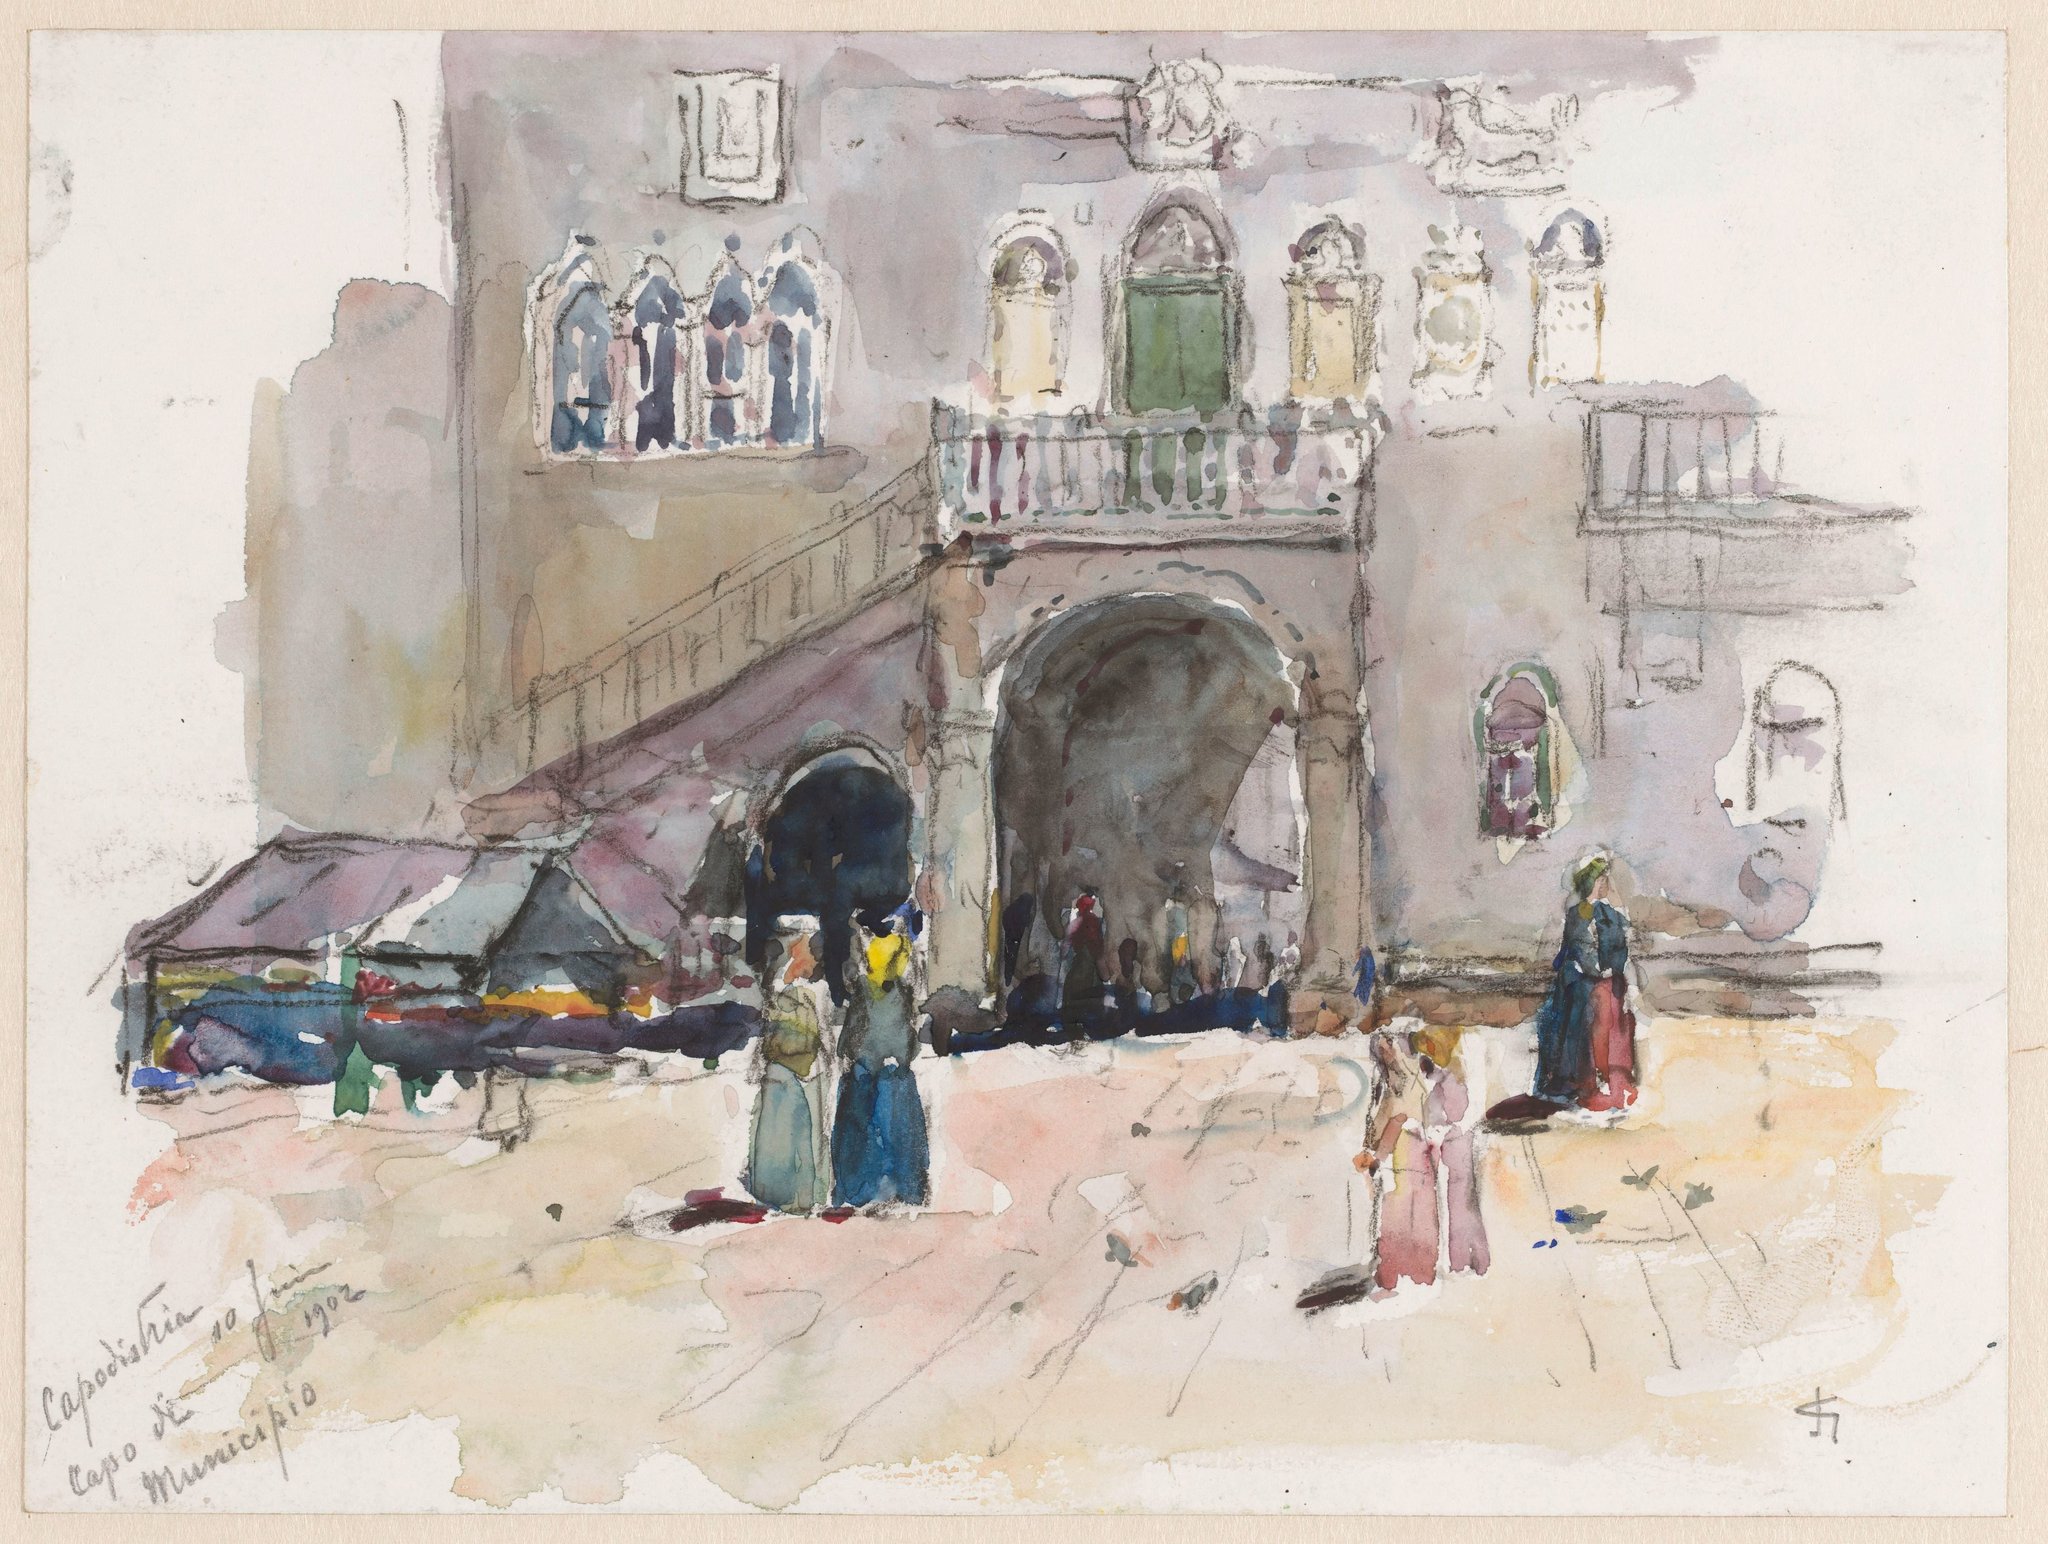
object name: watercolor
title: Stadhuis in Capodistria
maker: carel nicolaas storm van s-gravesande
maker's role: draughtsman, print maker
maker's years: 1841-1924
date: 1902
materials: chalk, paper, watercolor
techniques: brush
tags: townhall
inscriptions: date: ‘1902’